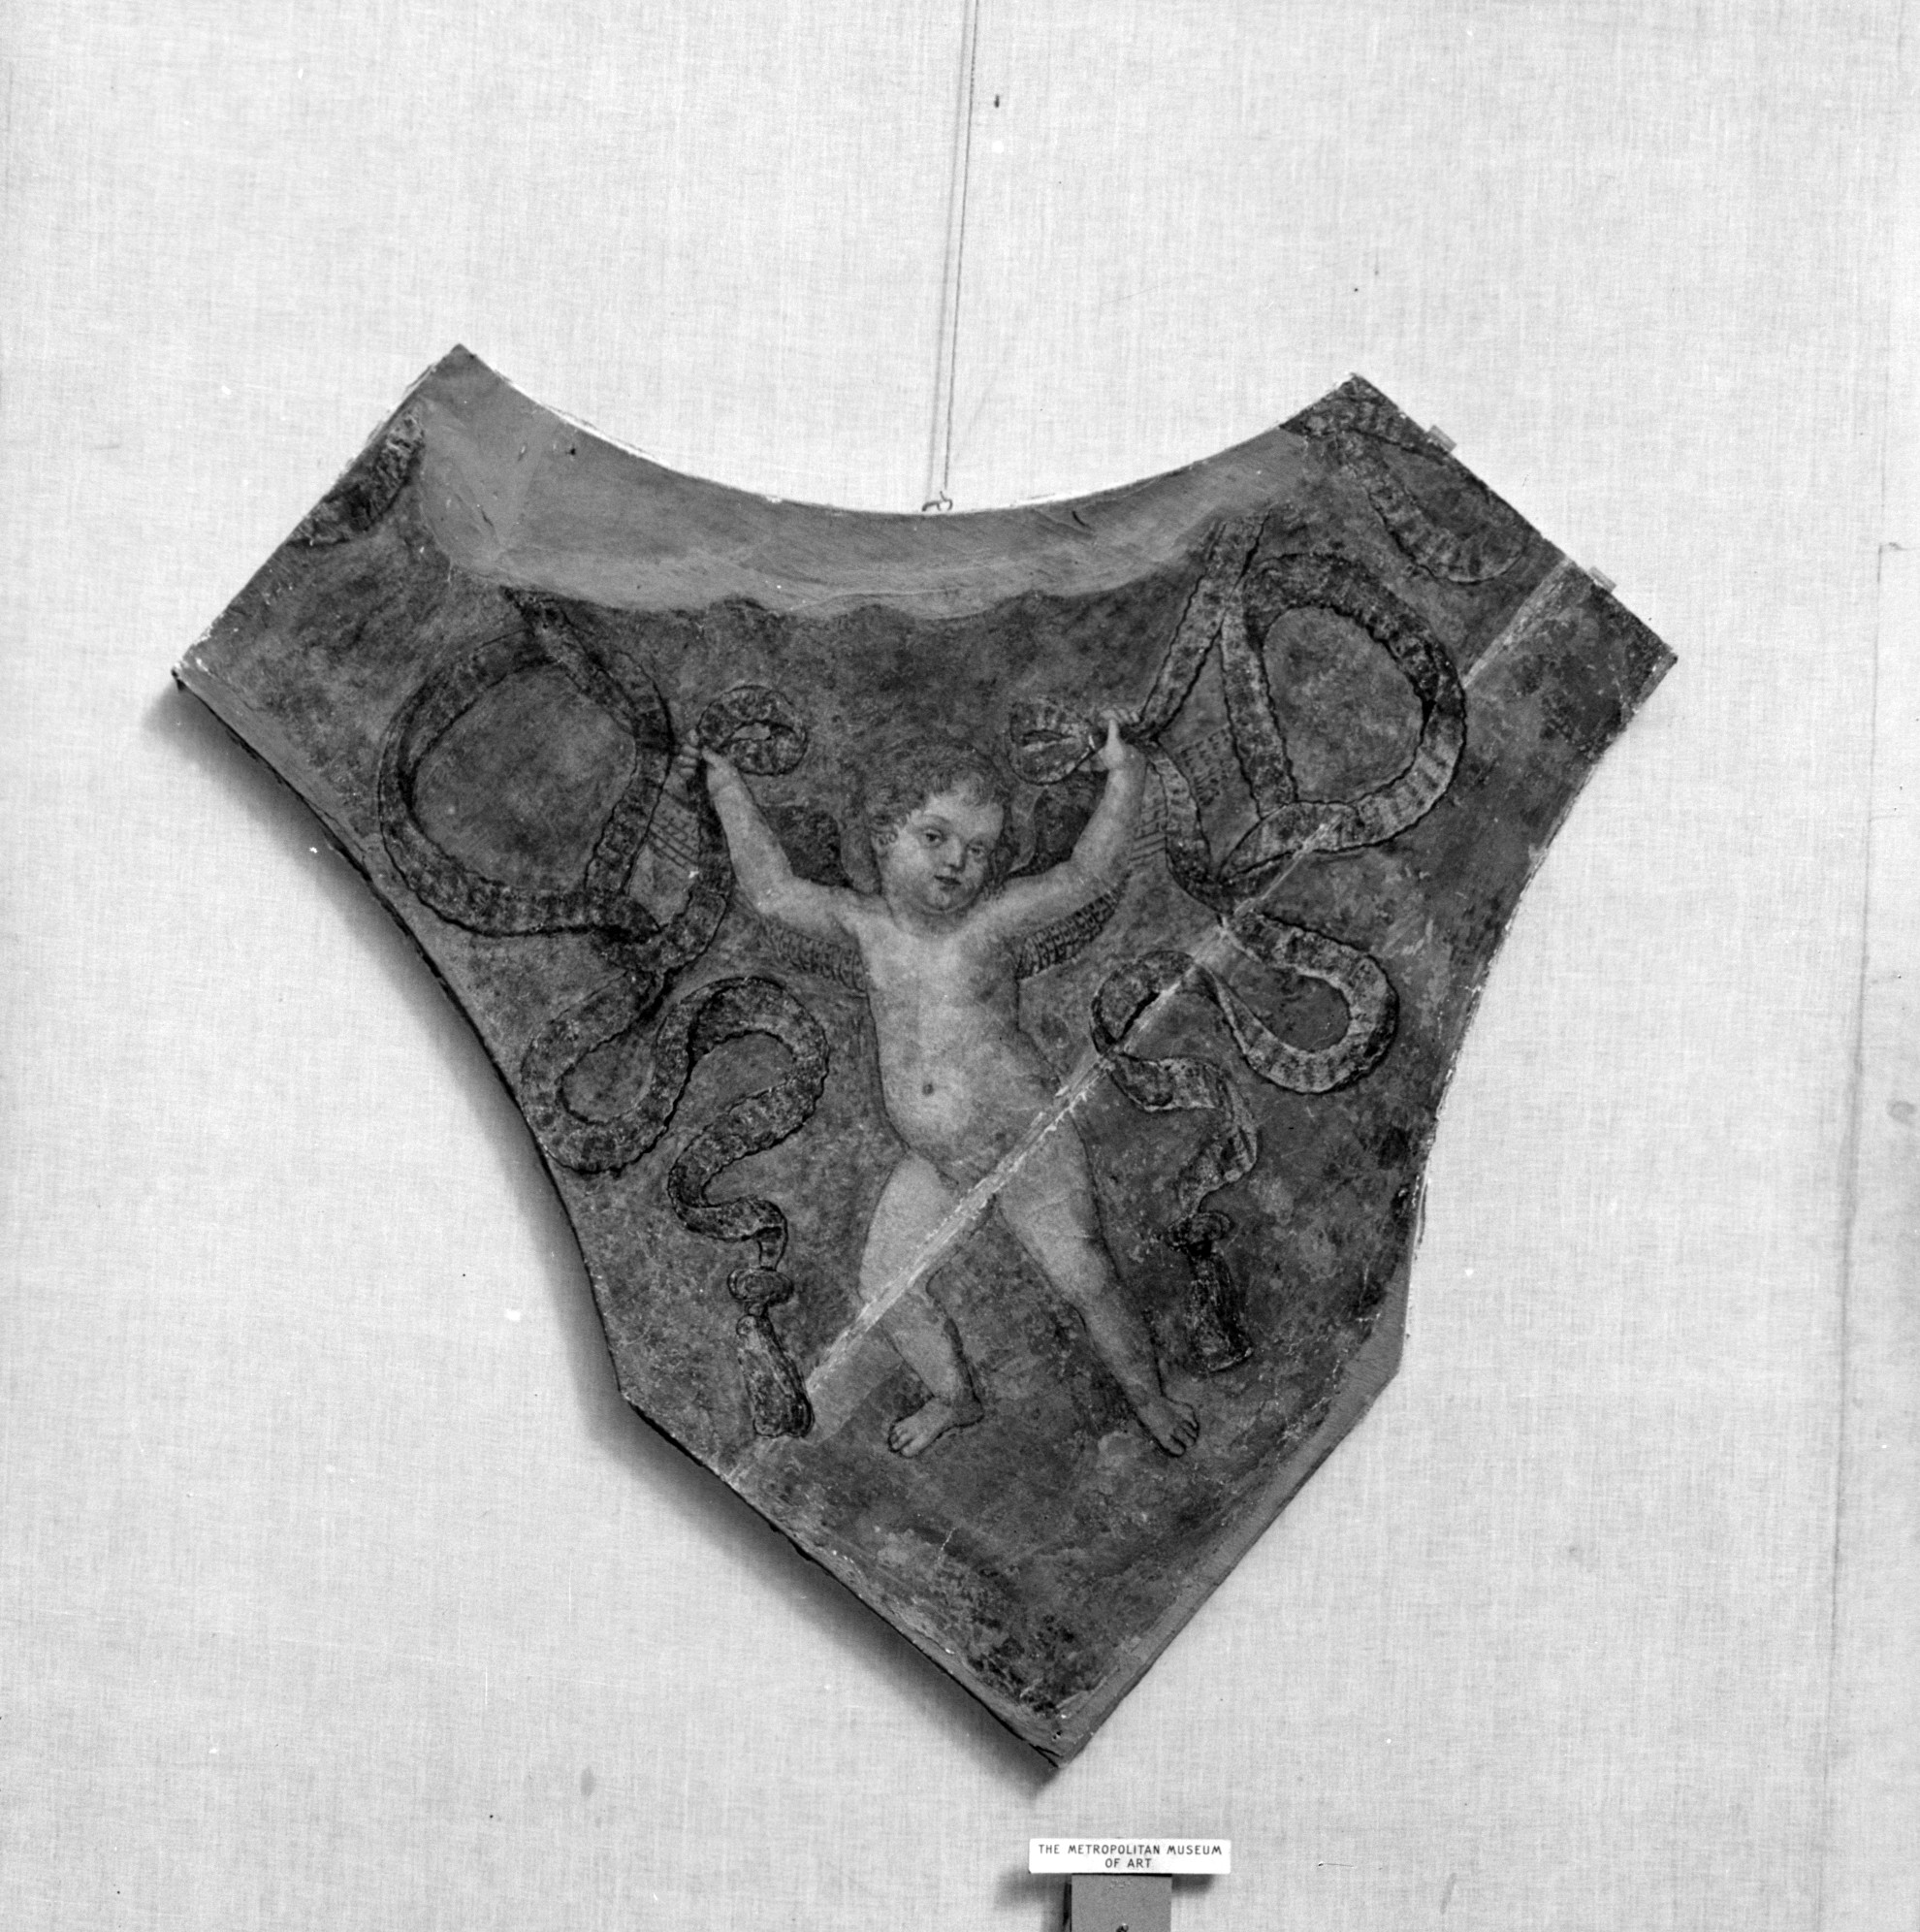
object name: ceiling panel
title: Putto with garlands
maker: pinturicchio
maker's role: artist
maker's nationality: italian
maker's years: 1454-1513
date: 1509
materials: canvas, panel, wood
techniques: fresco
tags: cupid